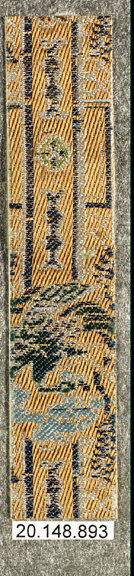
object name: piece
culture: chinese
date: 1701-1800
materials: silk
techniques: compound weave